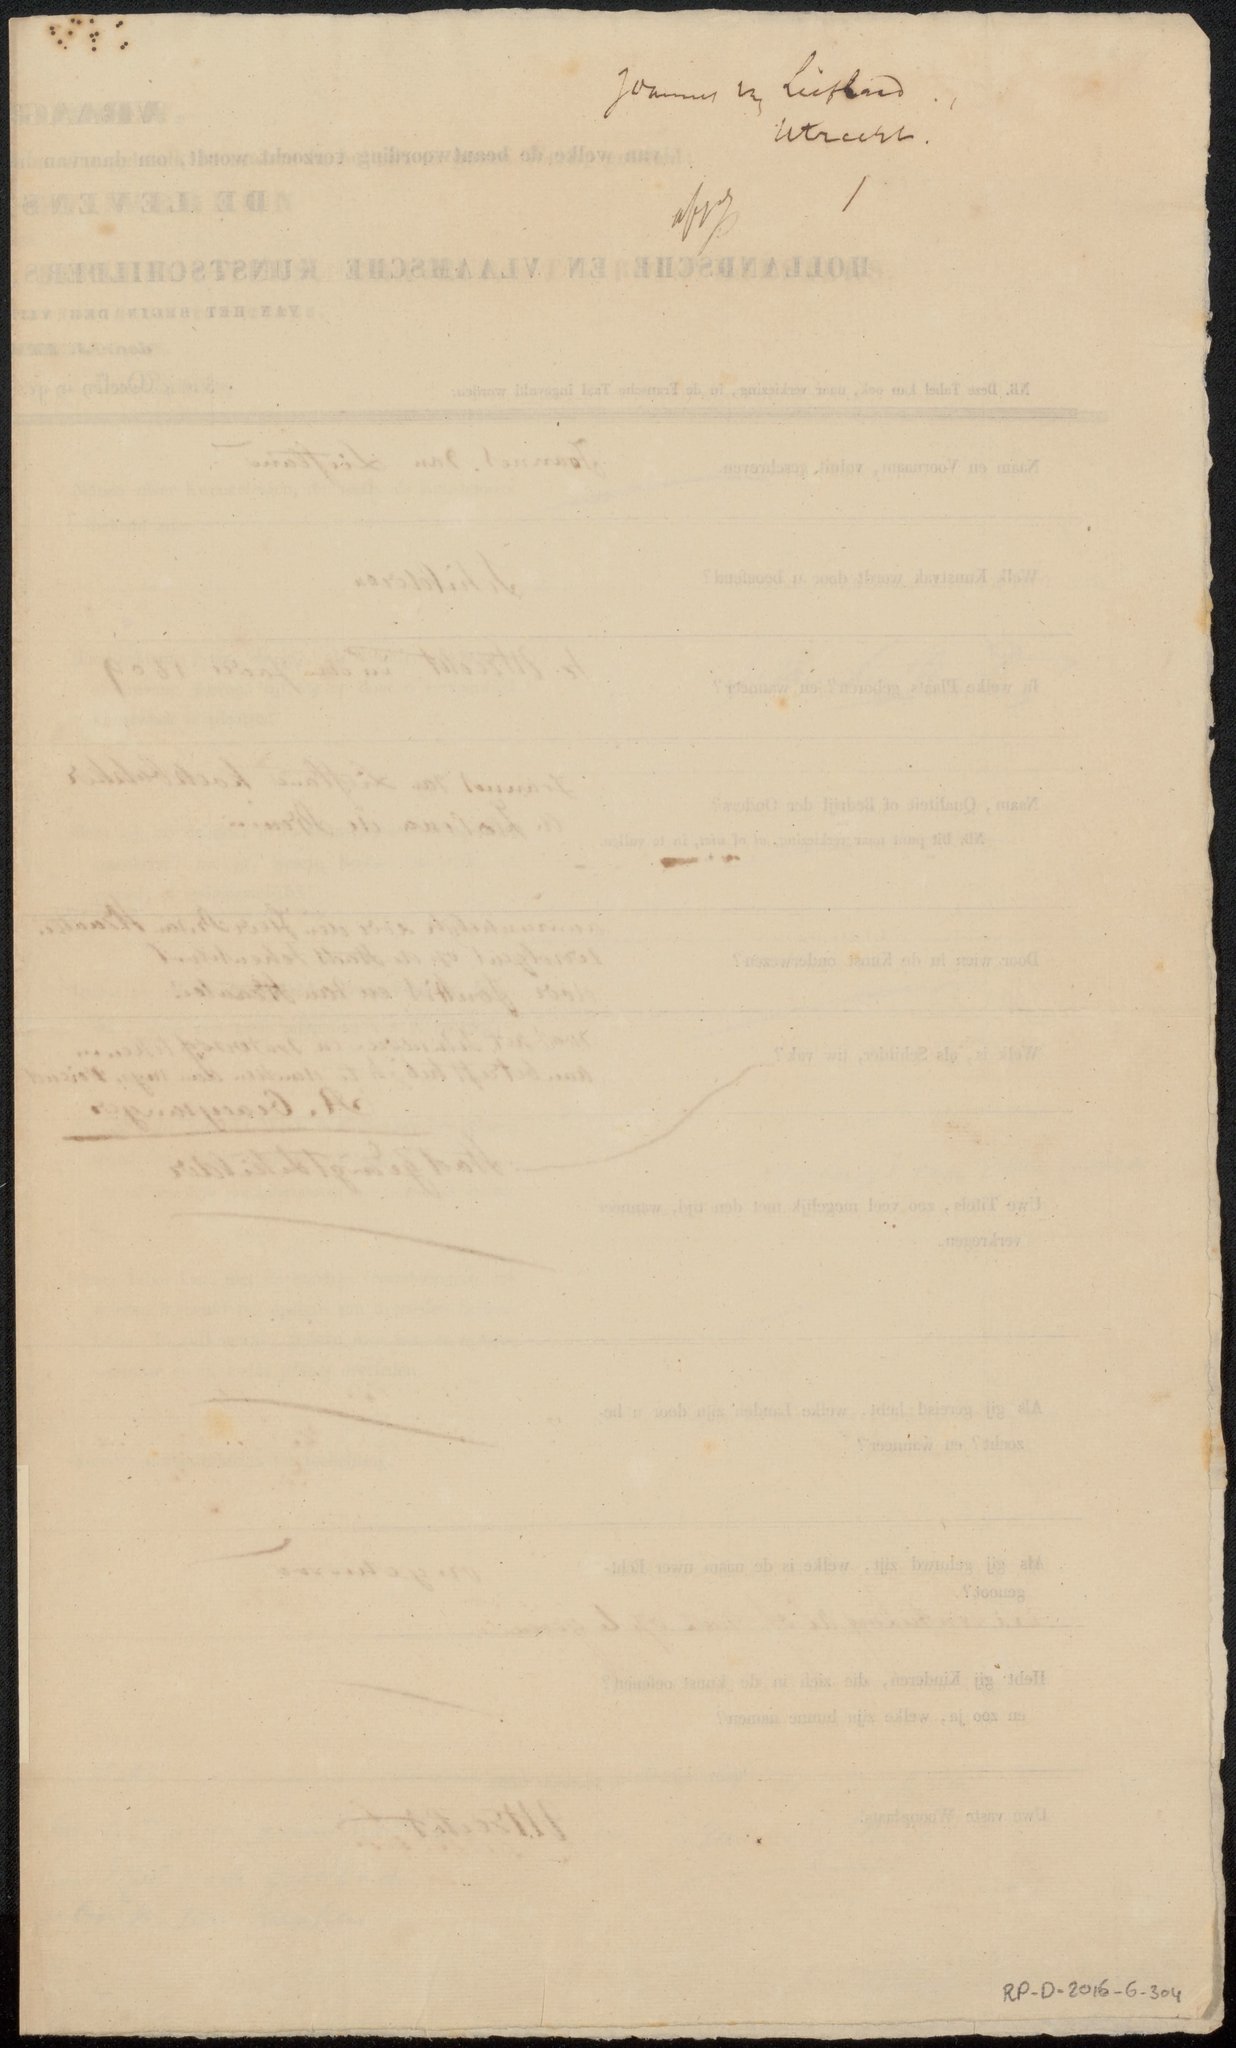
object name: questionnaire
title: Enquêteformulier ingevuld door Joannes van Liefland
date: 1840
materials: ink, paper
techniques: pen, printing, writing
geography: utrecht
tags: utrecht, print maker, joannes van liefland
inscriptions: watermark, inscription: ‘Vraagpunten,/ van welke de beantwoording verzocht wordt, om daarvan het noodig gebruik te maken in het uit te geven Werk, getiteld: De levens en werken/ der Hollandsche en Vlaamsche kunstschilders, beeldhouwers,/ graveurs en bouwmeesters, van het begin der vijftiende eeuw tot heden/ door J. Immerzeel, Jr.’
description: Opgenomen in: Immerzeel, J. Jr., De levens en werken der Hollandsche en Vlaamsche kunstschilders, beeldhouwers, graveurs en bouwmeesters, van het begin der vijftiende eeuw tot heden, Amsterdam: J.C. van Kesteren, 1842-1843.